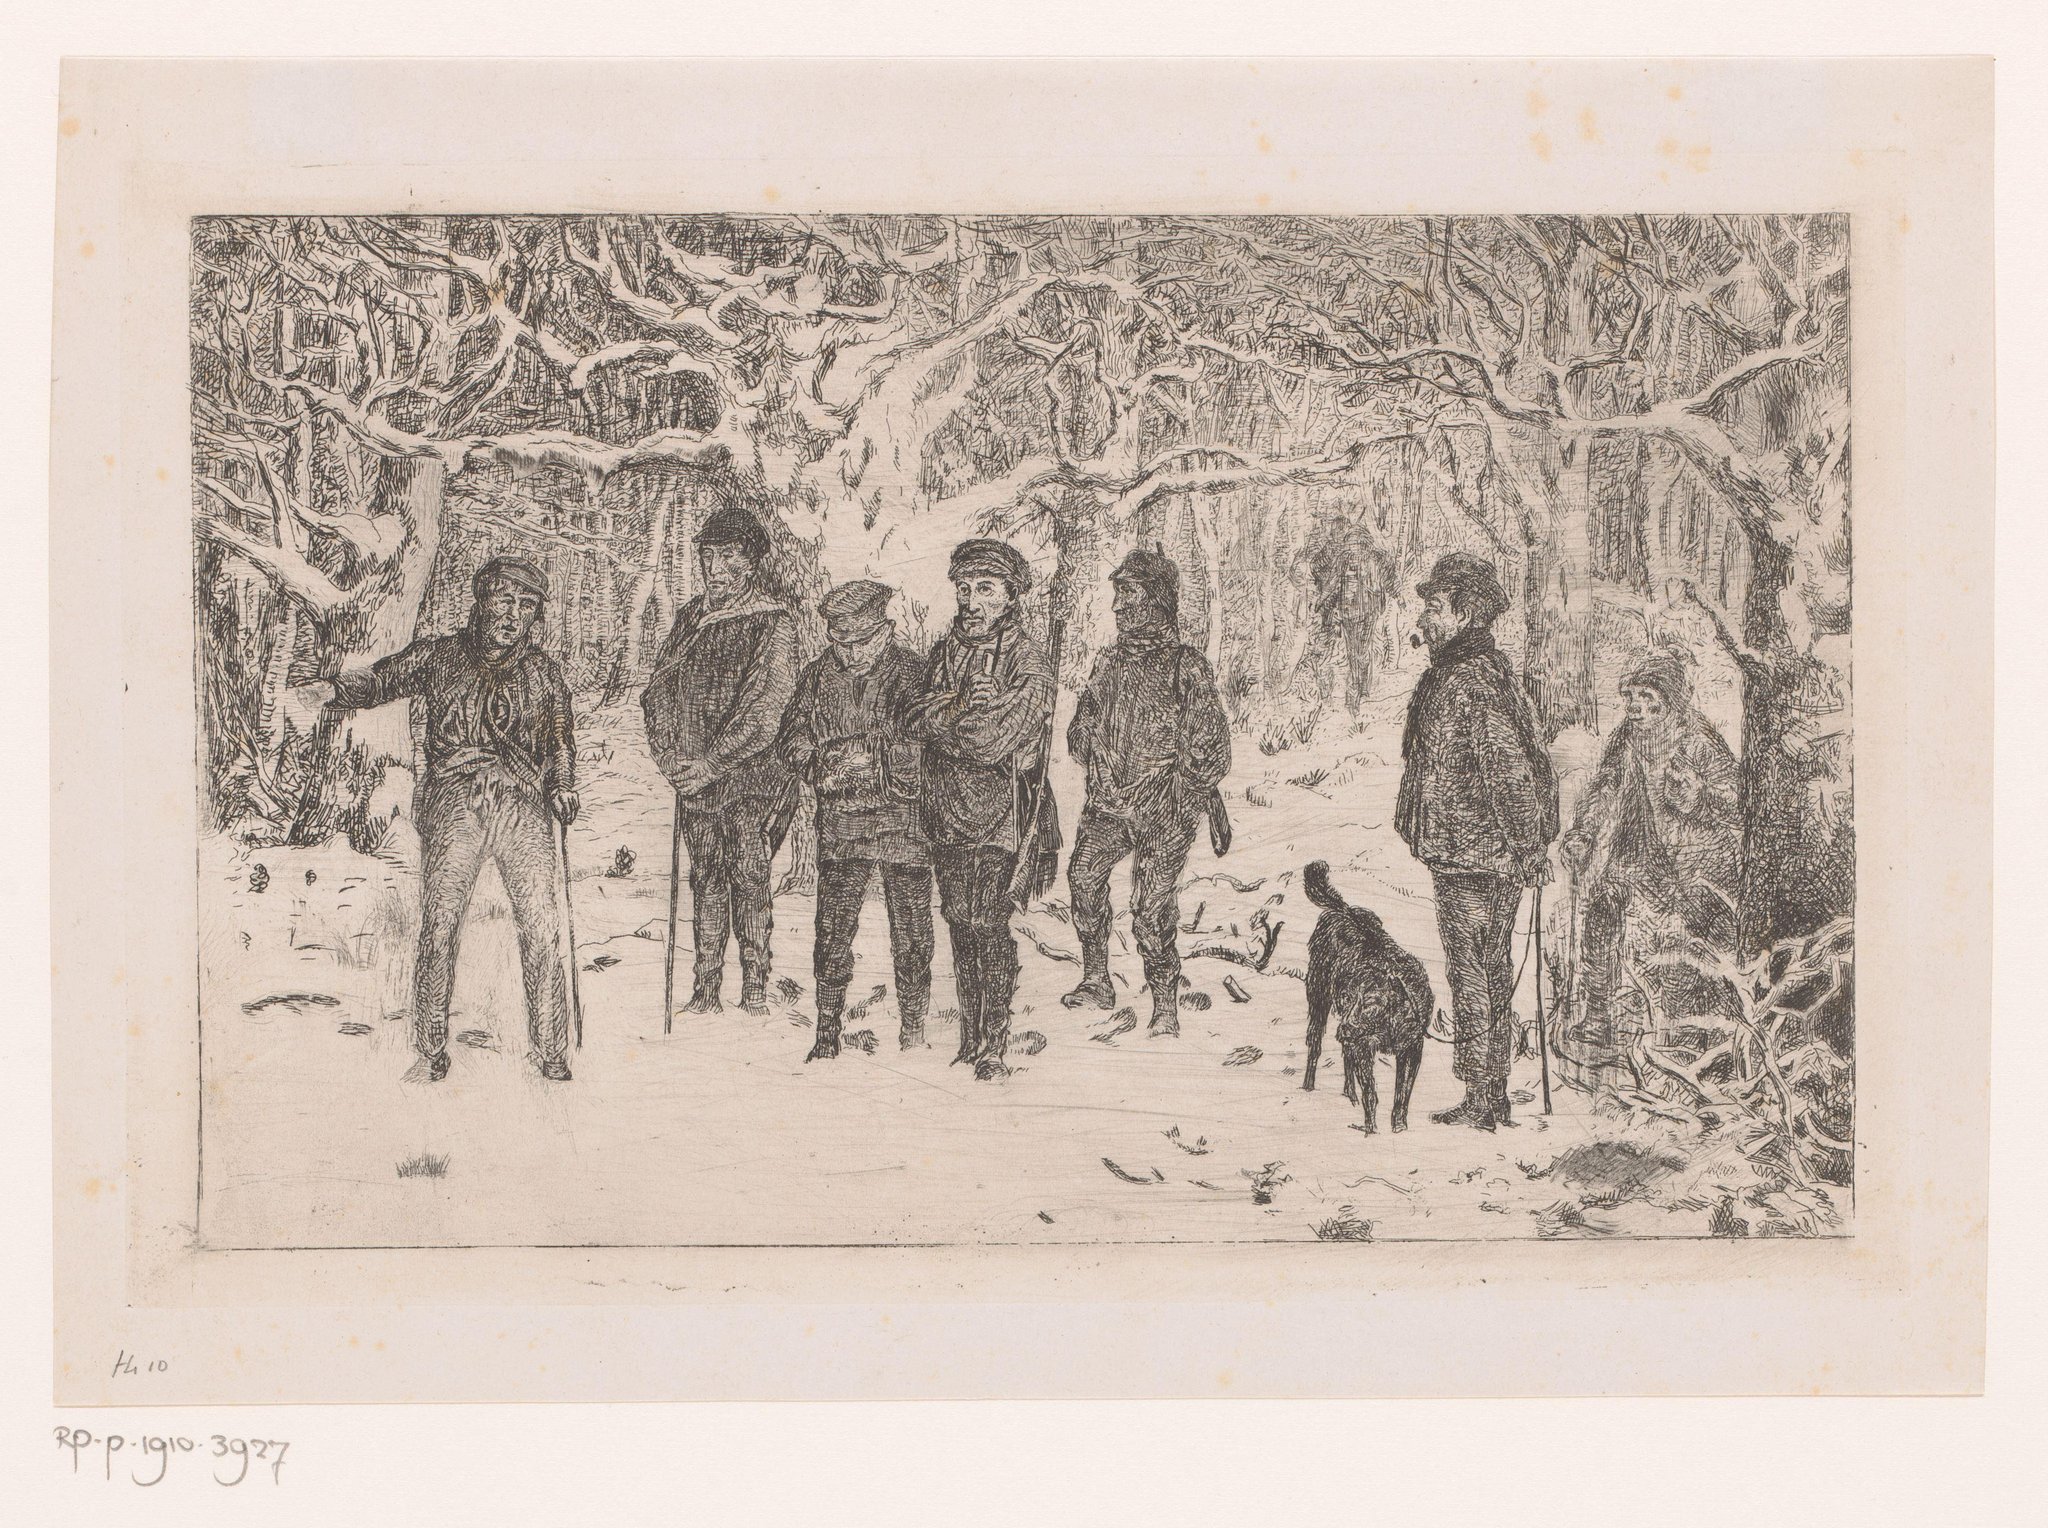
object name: print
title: Groep jagers en drijvers in een besneeuwd bos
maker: lambert jacquelart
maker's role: print maker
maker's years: 1820-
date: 1830-1910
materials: paper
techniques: etching, intaglio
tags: assembling, 'départ pour la chasse', beaters (~ hunt)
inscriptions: collector's mark: Lugt 2228, collector's mark: Lugt 1485